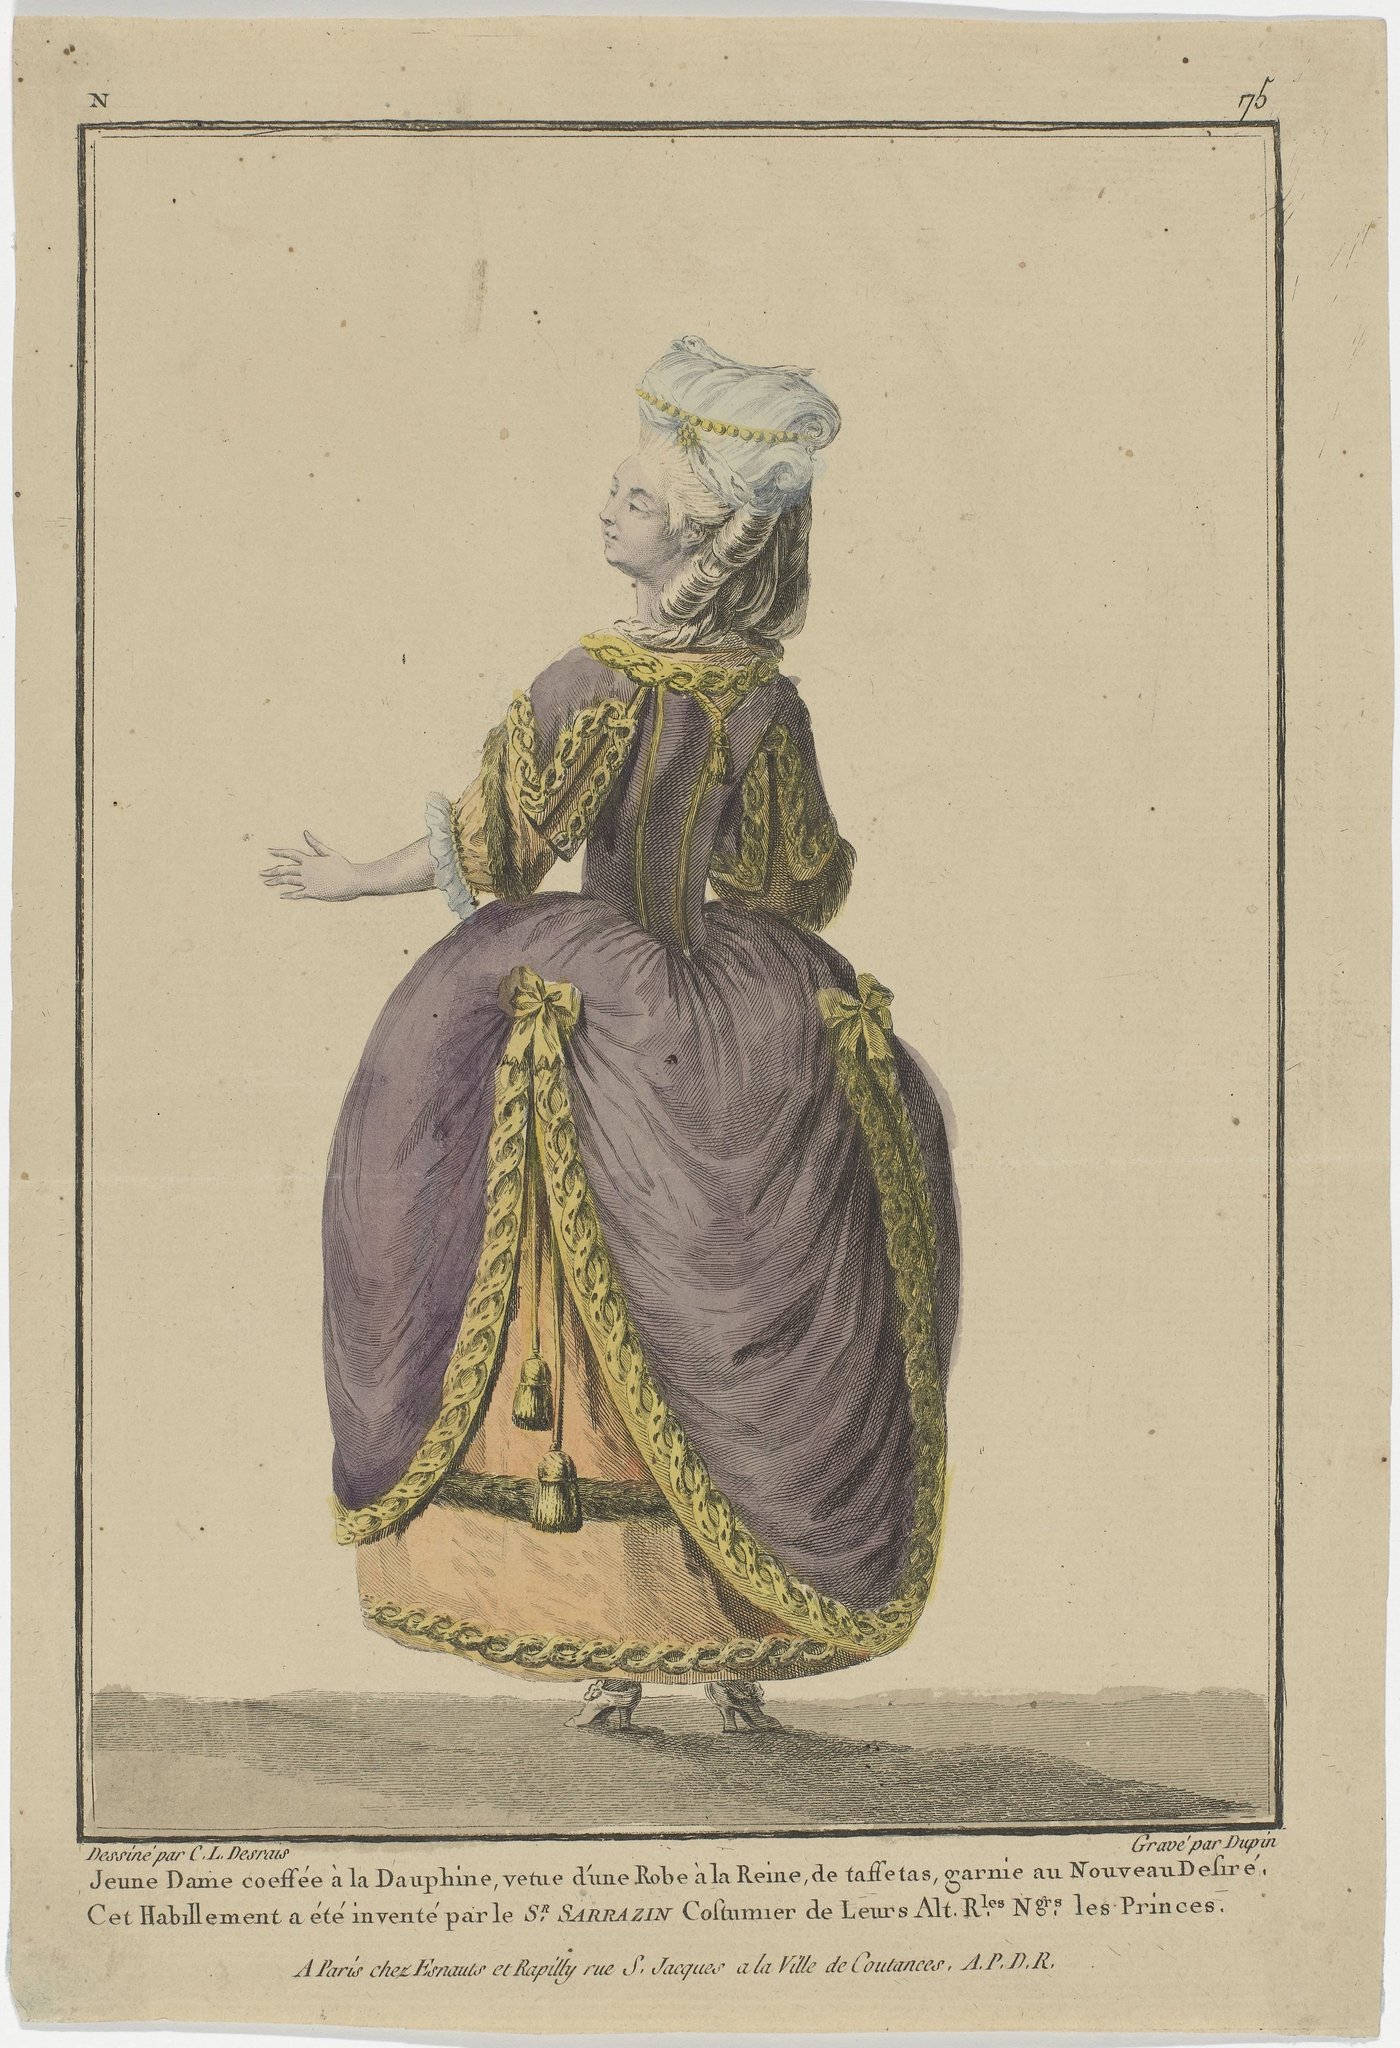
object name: fashion print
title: Gallerie des Modes et Costumes Français, 1778, N 75 : Jeune Dame coeffée a la Dauphin (...).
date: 1778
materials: paper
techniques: engraving, hand coloring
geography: paris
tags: border, ribbon, braid (+ women's clothes), dress, gown (robe à la reine) (+ women's clothes), styles of hairdress - aa - ~ women, head-gear (bonnet) (+ women's clothes), fashion plates, shoes, sandals (+ women's clothes), skirt (+ women's clothes), dress, gown (+ women's clothes)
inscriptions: caption: ‘Jeune Dame coeffée à la Dauphine, vetue d'une Robe à la Reine, de taffetas, garnie au Nouveau Desiré. Cet Habillement a été inventé par le Sr. Sarrazin Costumier de Leurs Alt. Rles. Ngrs. les Princes.’, address: ‘A Paris chez Esnauts et Rapilly, rue S. Jacques a la Ville de Coutances. A.P.D.R.’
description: Staande jonge vrouw, op de rug gezien, met kapsel 'à la Dauphine'. Zij draagt in een 'robe à la Reine' van tafzijde, gegarneerd met bont, koorden, strikken en kwasten. Hieronder een rok, afgezet met koorden en bont. De japon is ontworpen door Sarrazin, 'costumier' van de koninklijke familie. Accessoires: bonnet (muts) met kralensnoer, schoenen met hakken en rozetten. Prent uit serie N. 13e Cahier de Modes Françaises, 7e Suite d'Habillemens à la mode, Gallerie des Modes et Costumes Français.